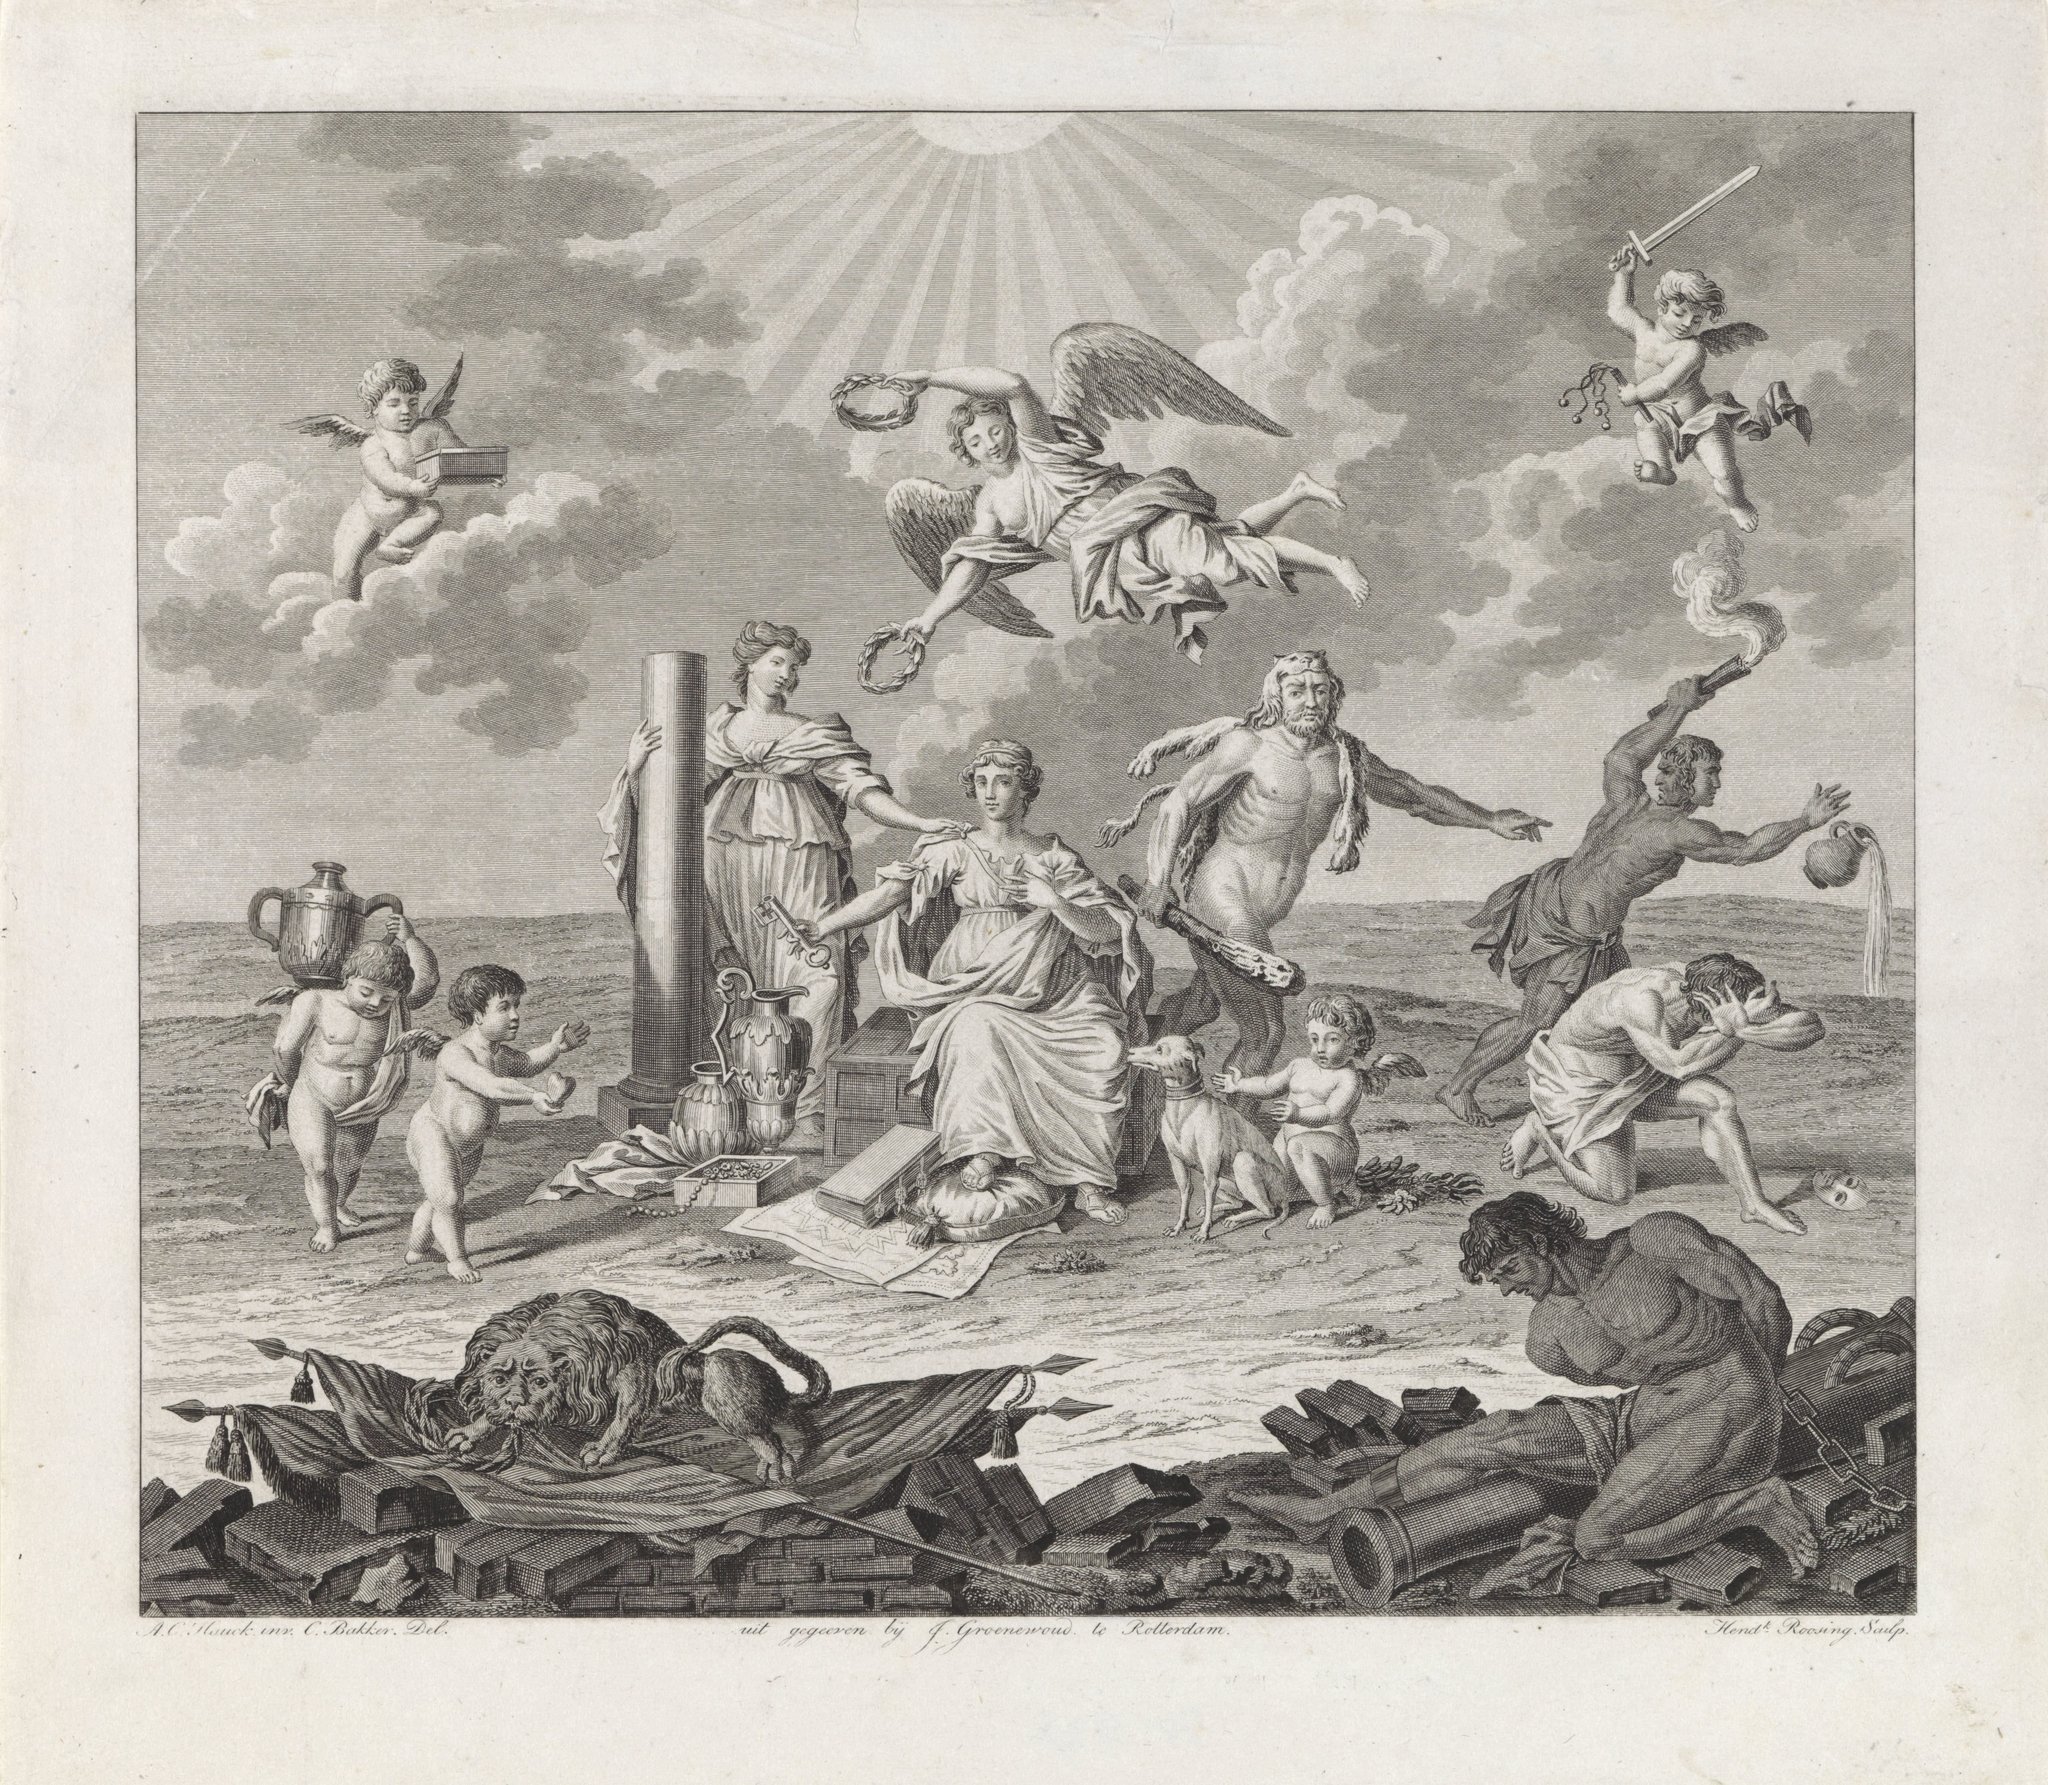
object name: print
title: Vier allegorieën op de omwenteling in 1795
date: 1795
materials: paper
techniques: engraving, etching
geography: rotterdam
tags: fidelity; 'fedeltà' (ripa) (+ abstract concept represented by female figure)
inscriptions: collector's mark: Lugt 2228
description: Allegorie op de Getrouwheid, 1795. Getrouwheid zetelt op een kist, sleutel in haar hand, onder voetkussen plattegronden voor vestingwerken, naast haar een hond. Links van haar Standvastigheid of Kracht, rechts verjaagt Hercules Janus (Dubbelhartigheid met vuur en water) en Bedrog. Twee engeltjes komen een hart en een kruik aanbieden. Op de voorgrond de Nederlandse leeuw en een geboeide man (mogelijk Oorlog).